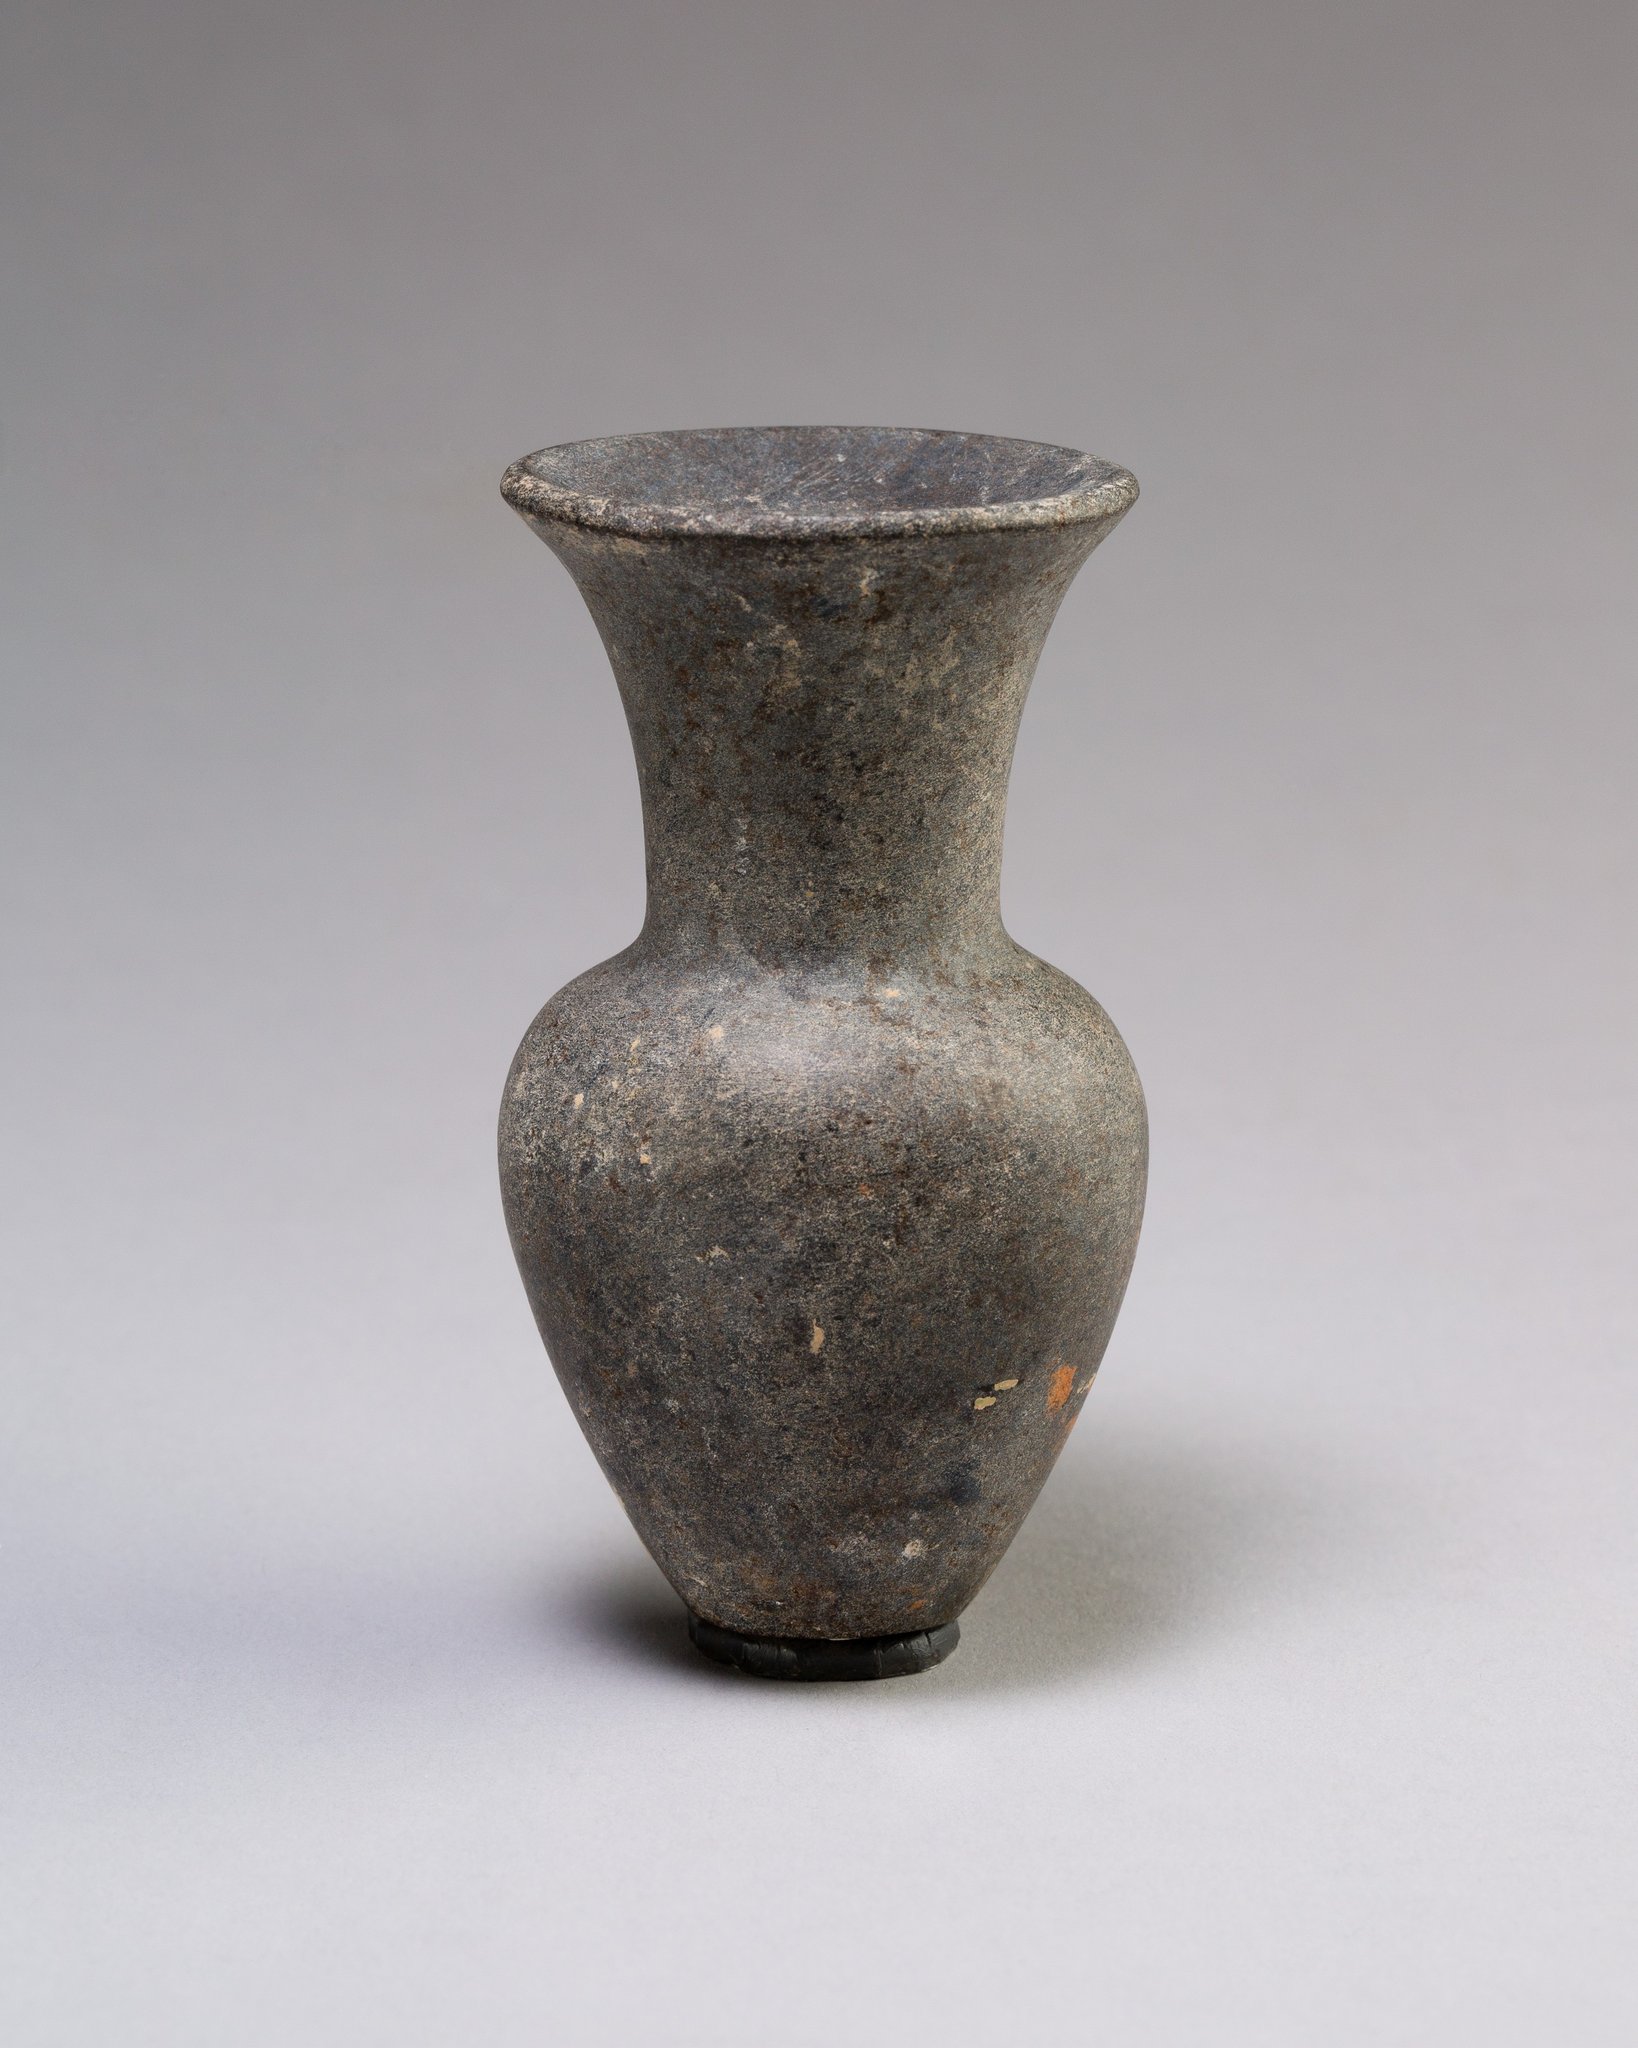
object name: vessel, opening of the mouth, perneb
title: "Opening of the Mouth" vessel of Perneb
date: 2381-2323 BCE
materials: stone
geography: egypt